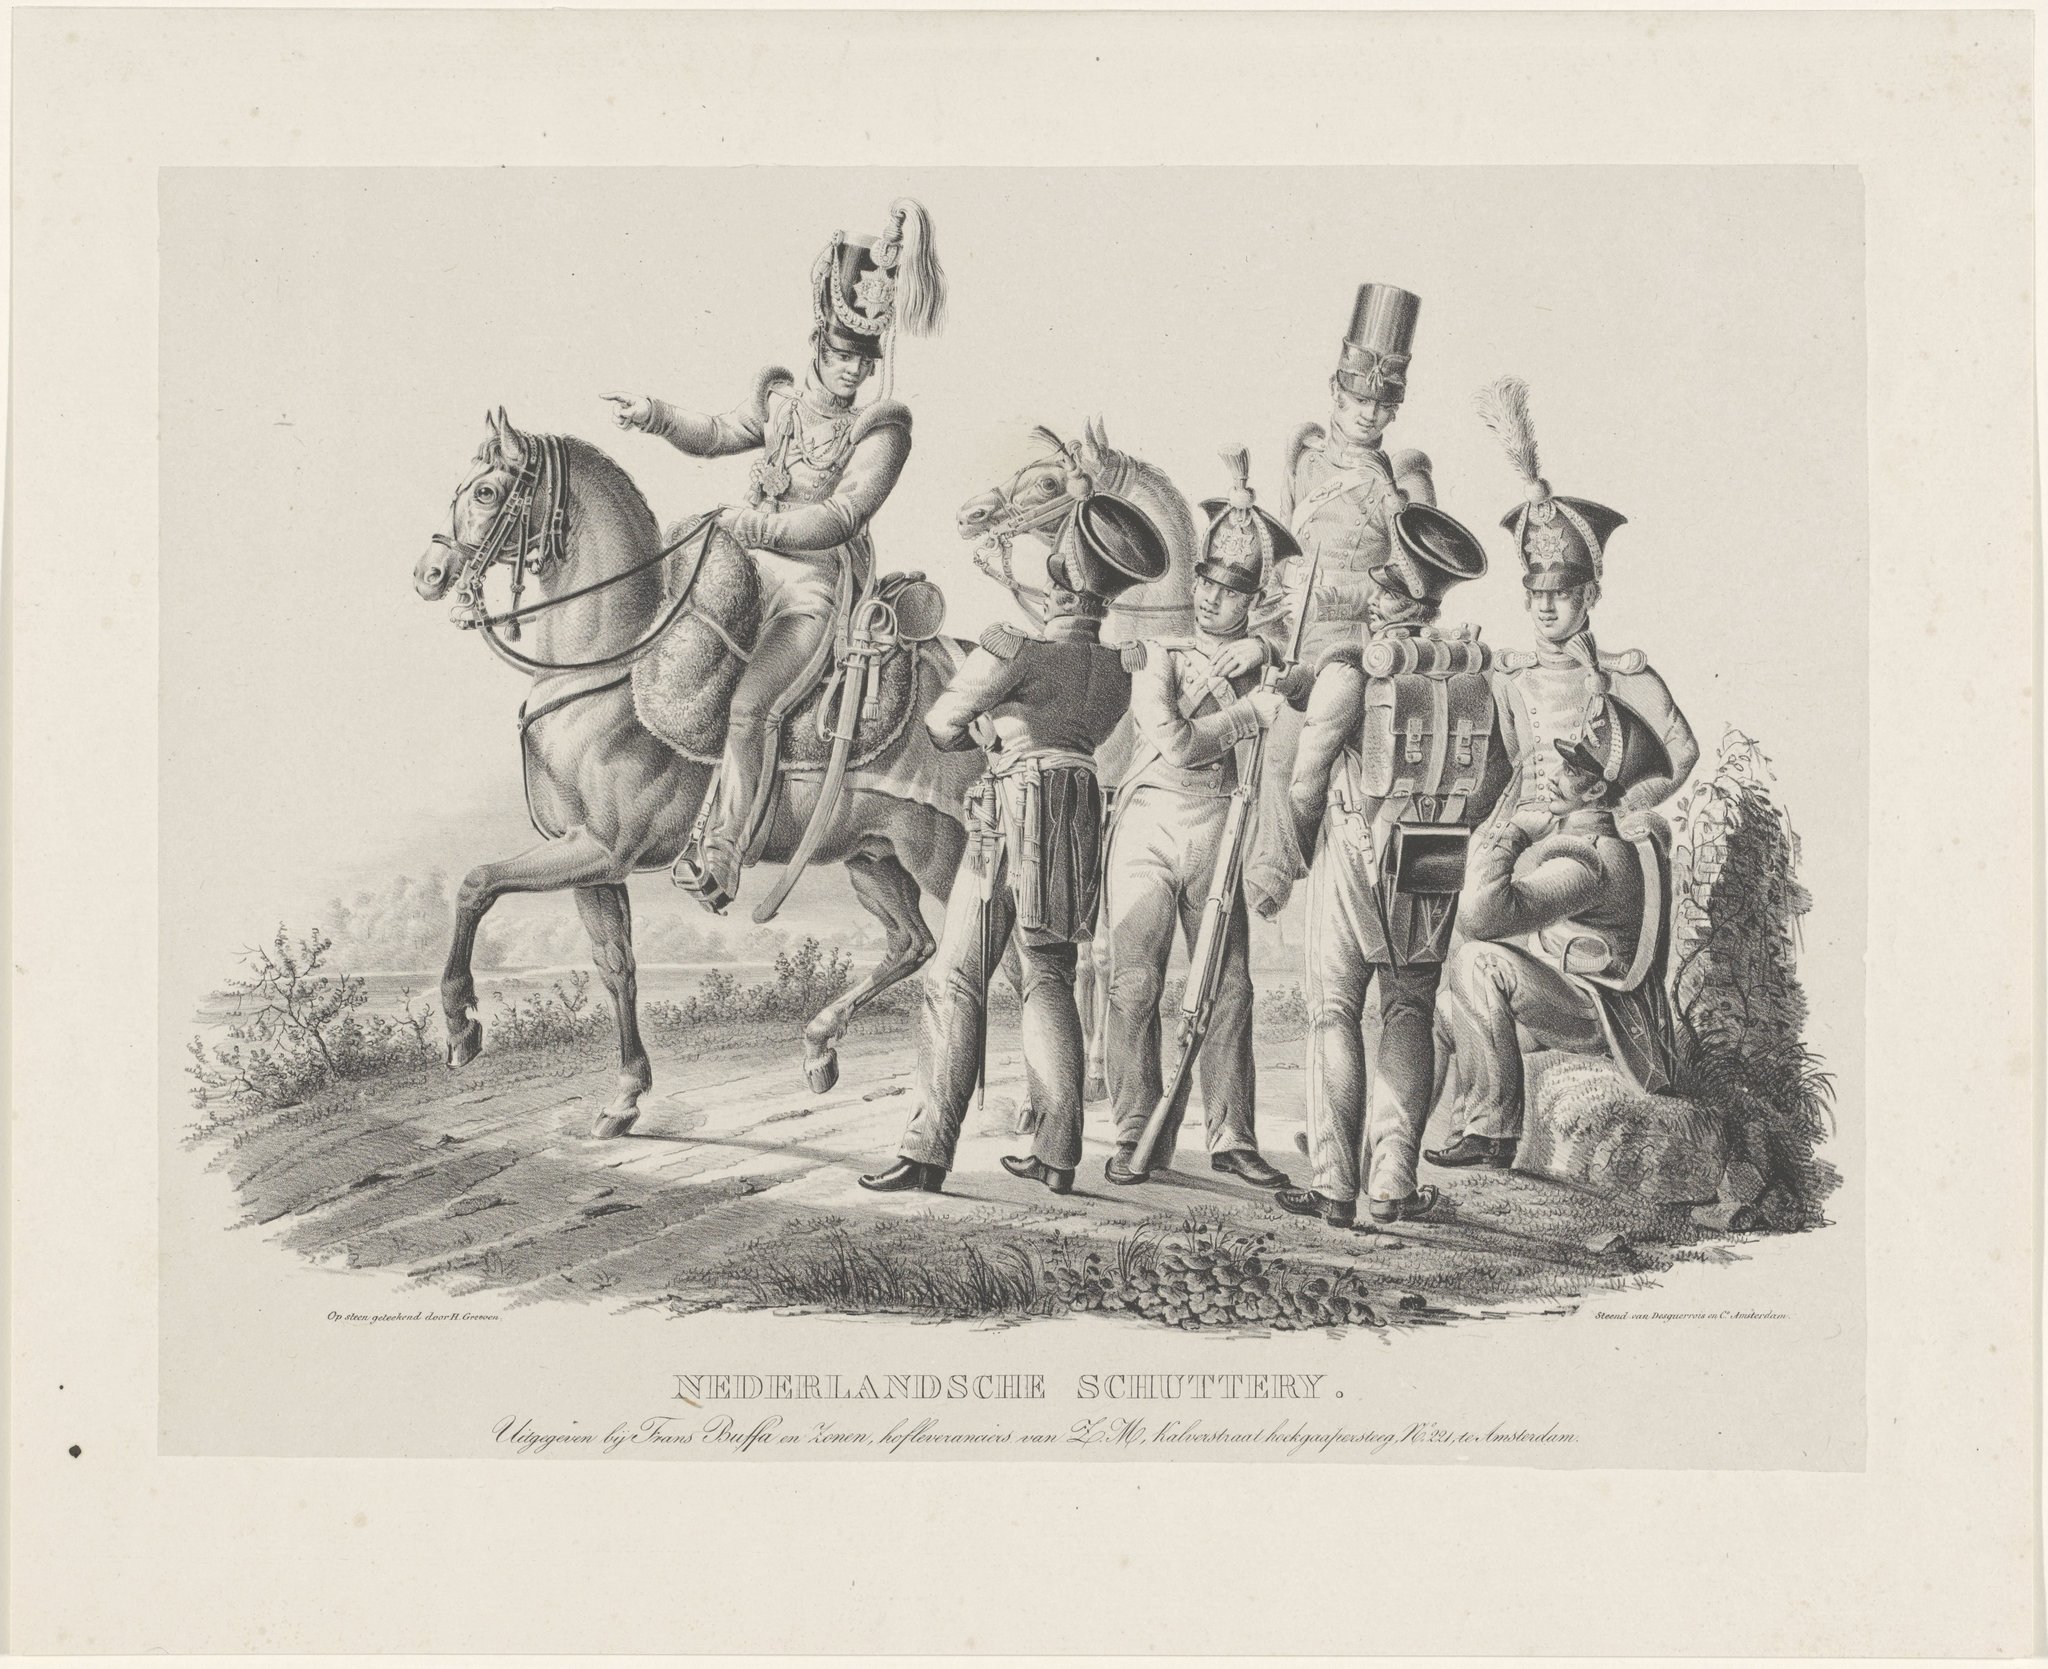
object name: costume print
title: Nederlandse Schutterij, 1830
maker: hendrik greeven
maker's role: painter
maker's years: 1787-1854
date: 1830-1831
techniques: printmaking, lithograph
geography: netherlands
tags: (military) uniforms, clothes, costume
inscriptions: collector's mark: Lugt 2228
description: Uniformen van zeven militairen van de Nederlandse Schutterij, ca. 1830. Twee mannen te paard bij vijf staande en zittende figuren. Uitgebeeld zijn: een officier, twee schutters, een schutter van de artillerie, een muzikant, een vrijwillige schutter van Amsterdam en een vrijwillige schutter van Den Haag.